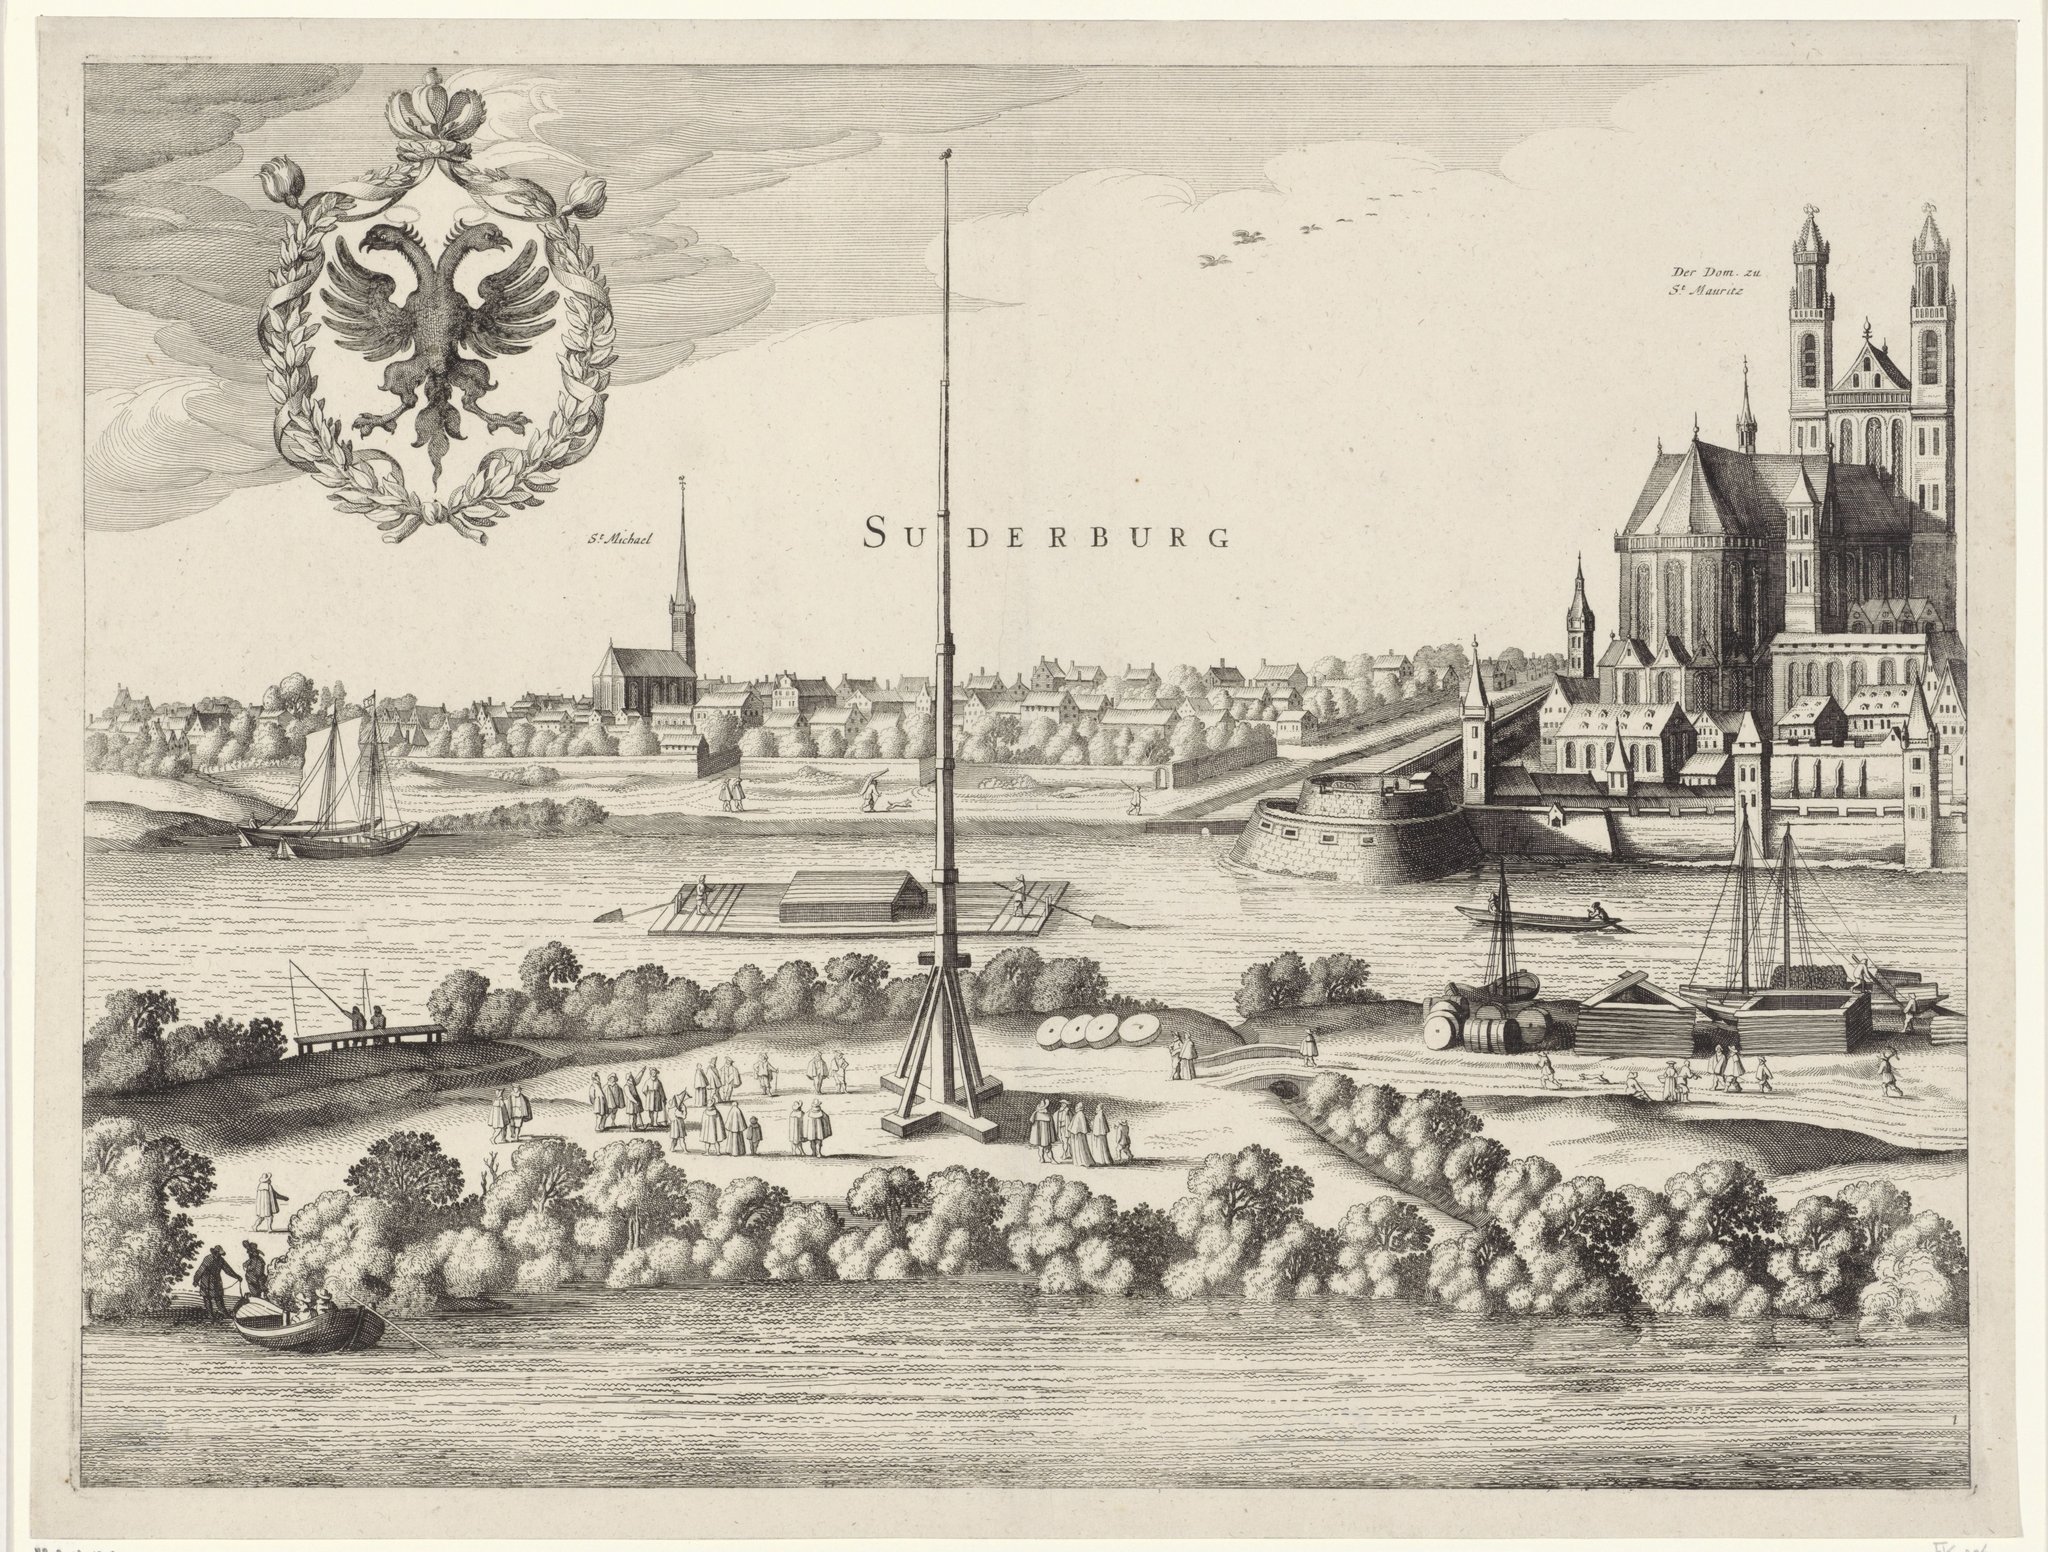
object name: print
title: Gezicht op Maagdenburg, linker blad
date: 1637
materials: paper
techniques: etching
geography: amsterdam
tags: prospect of village, silhouette of village, shooting-the-bird (on a high pole)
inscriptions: collector's mark: Lugt 2165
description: Panorama van Maagdenburg, gezien van de overzijde van de Elbe naar het westen. Rechts de Dom van Maagdenburg. Linksboven het keizerlijke wapen van het Heilige Roomse Rijk. Links op de voorgrond een groep figuren bezig met vogelschieten, waarbij een schutter met zijn kruisboog een houten vogel van een paal tracht te schieten.